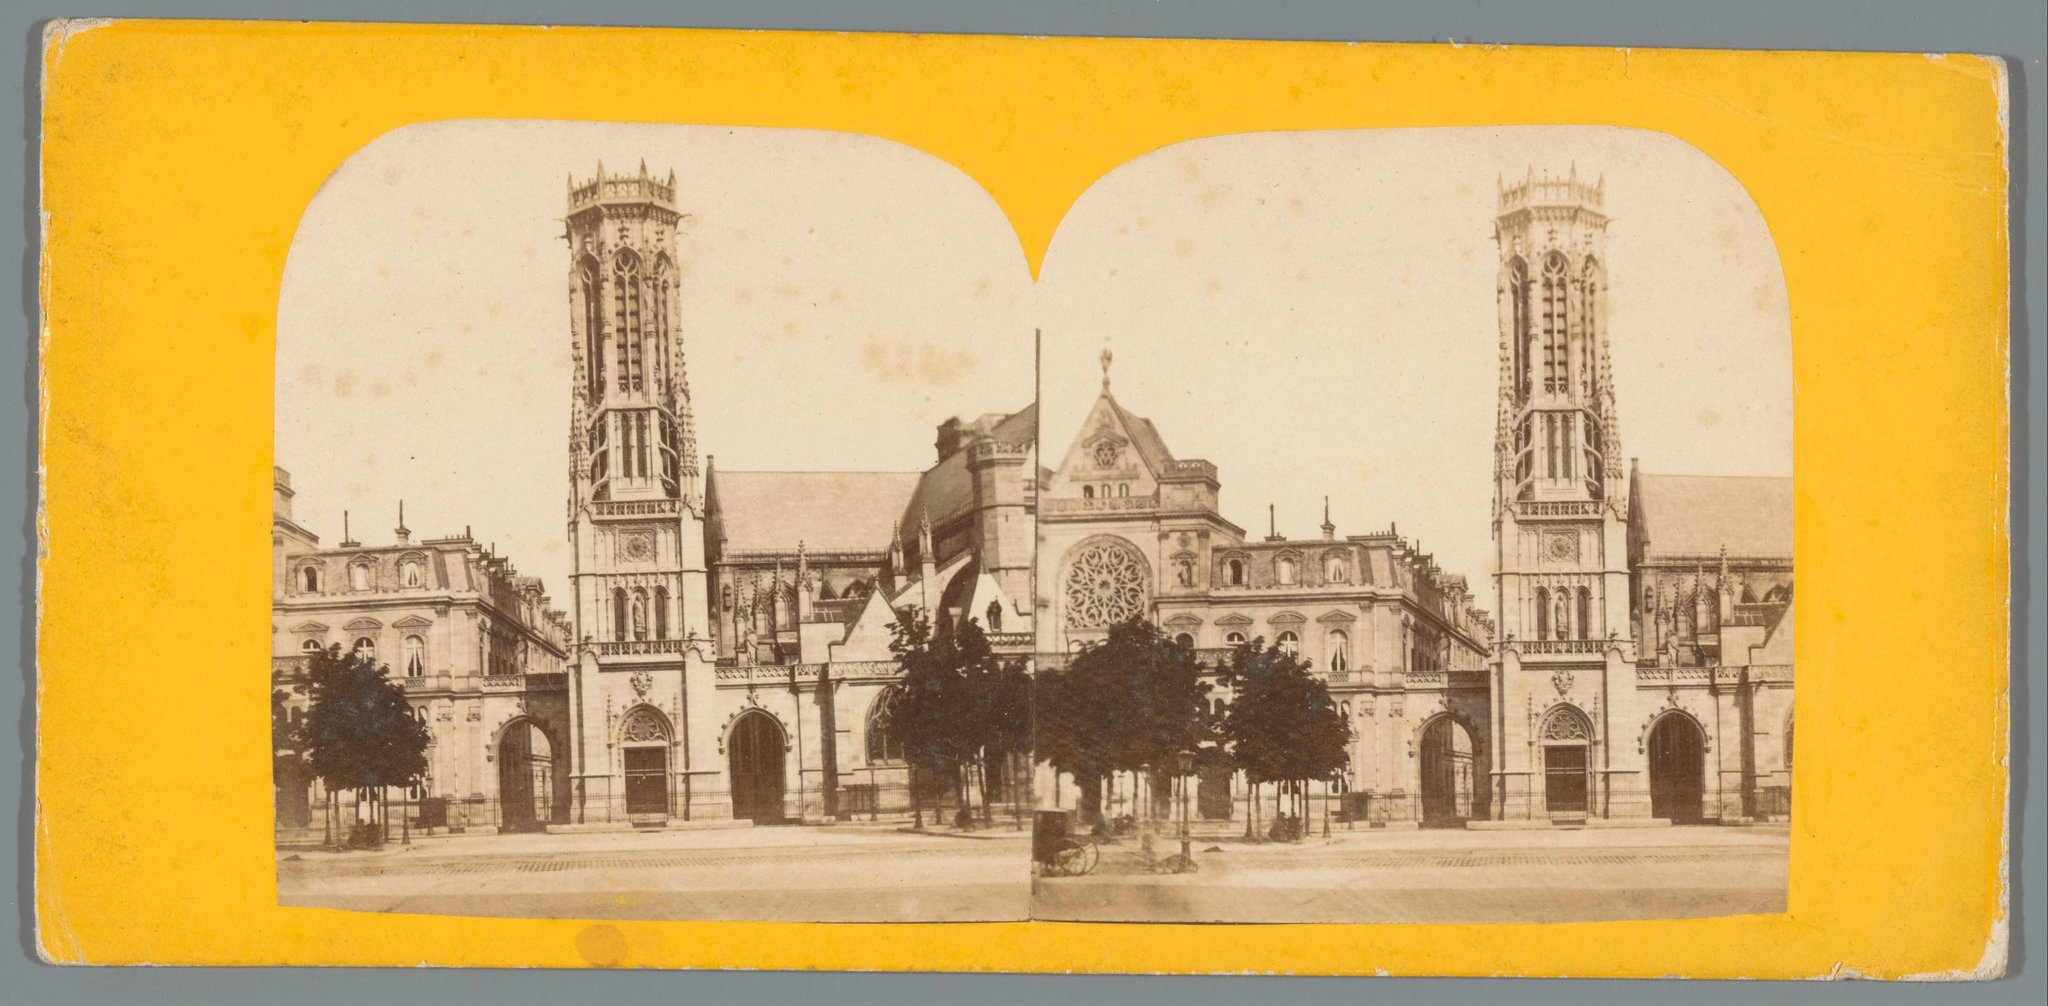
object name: stereograph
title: Gezicht op de klokkentoren van de Église Saint-Germain-l'Auxerrois in Parijs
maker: Anonymous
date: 1850-1880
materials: cardboard, photographic support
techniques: albumen print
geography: paris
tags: church (exterior), parts of church exterior and annexes: tower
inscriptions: number: ‘No 10667 [...]’, inscription: ‘St Germaint laurroix’